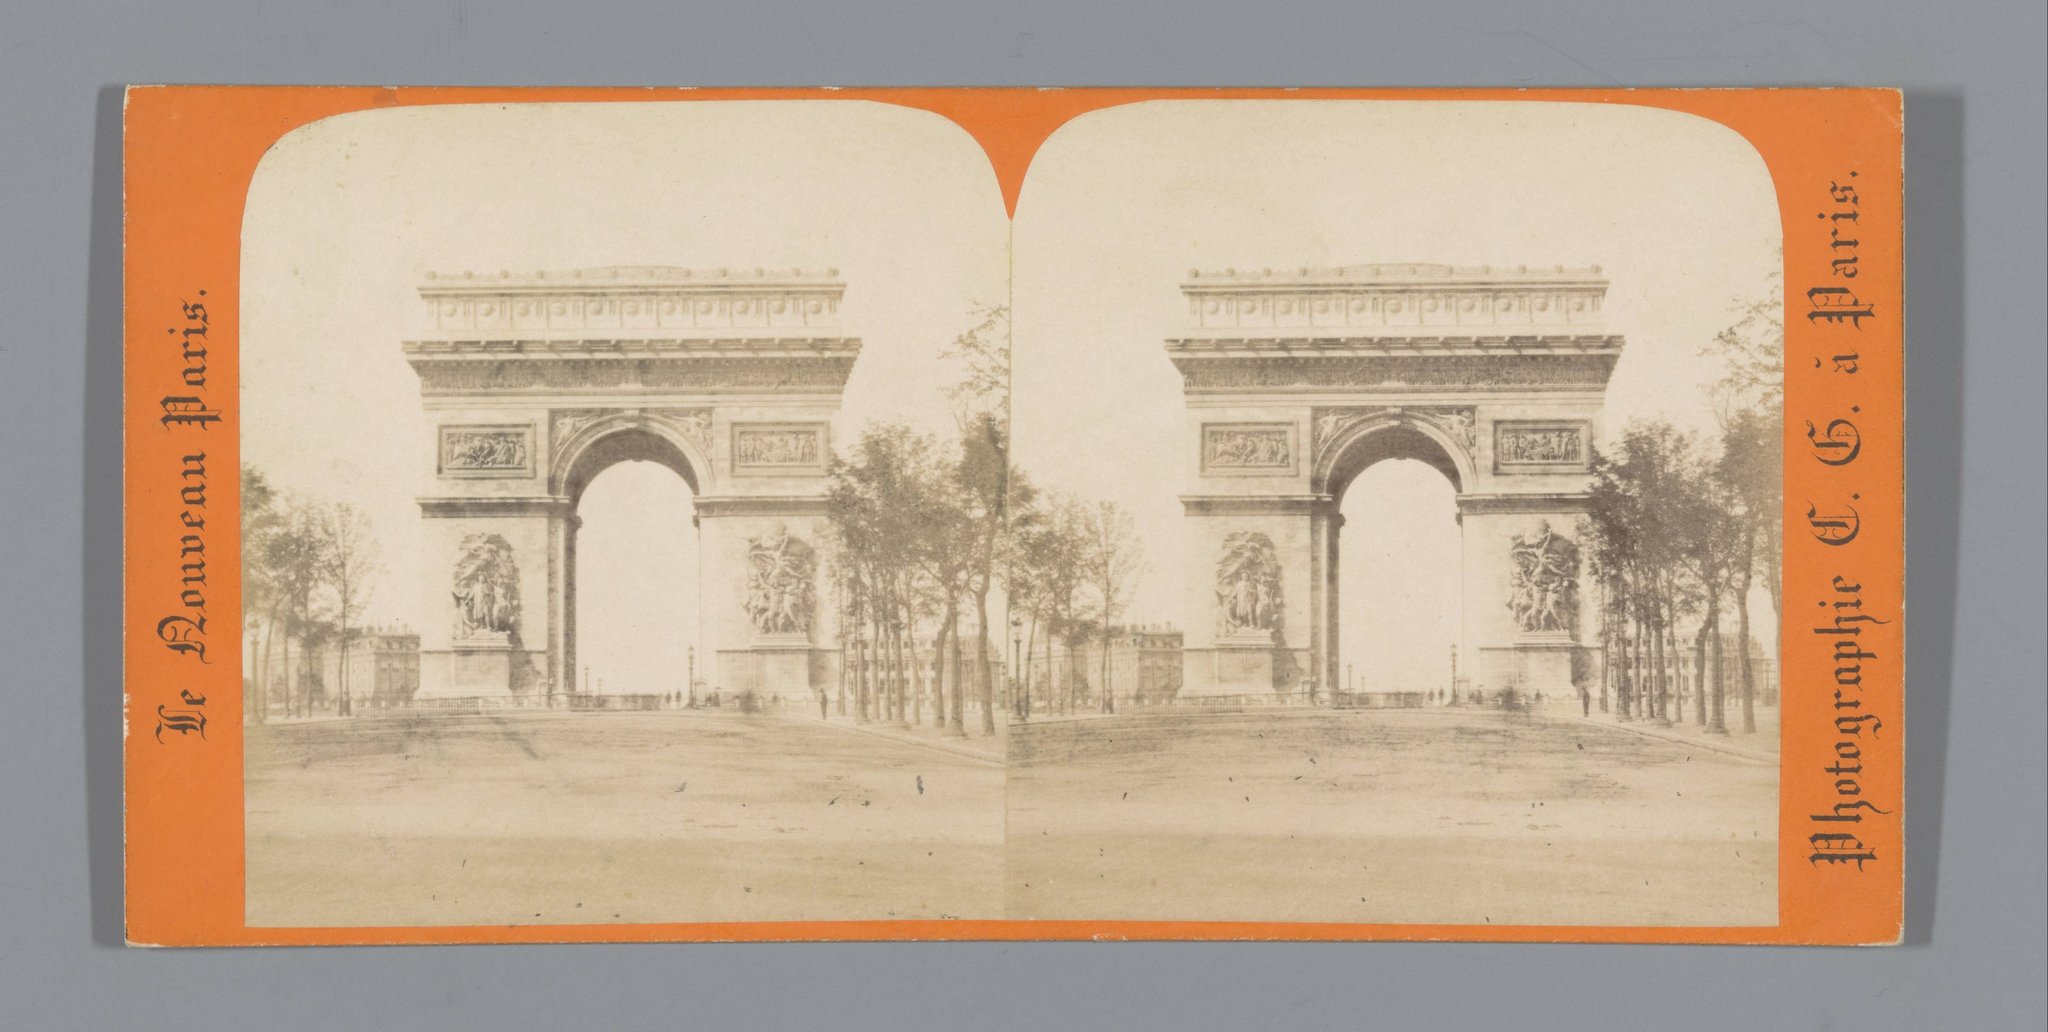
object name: stereograph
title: Le Nouveau Paris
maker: charles gérard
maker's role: fotograaf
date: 1850-1875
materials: cardboard, photographic support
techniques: albumen print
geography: paris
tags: triumphal arch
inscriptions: inscription: ‘Arc de l'etoile’